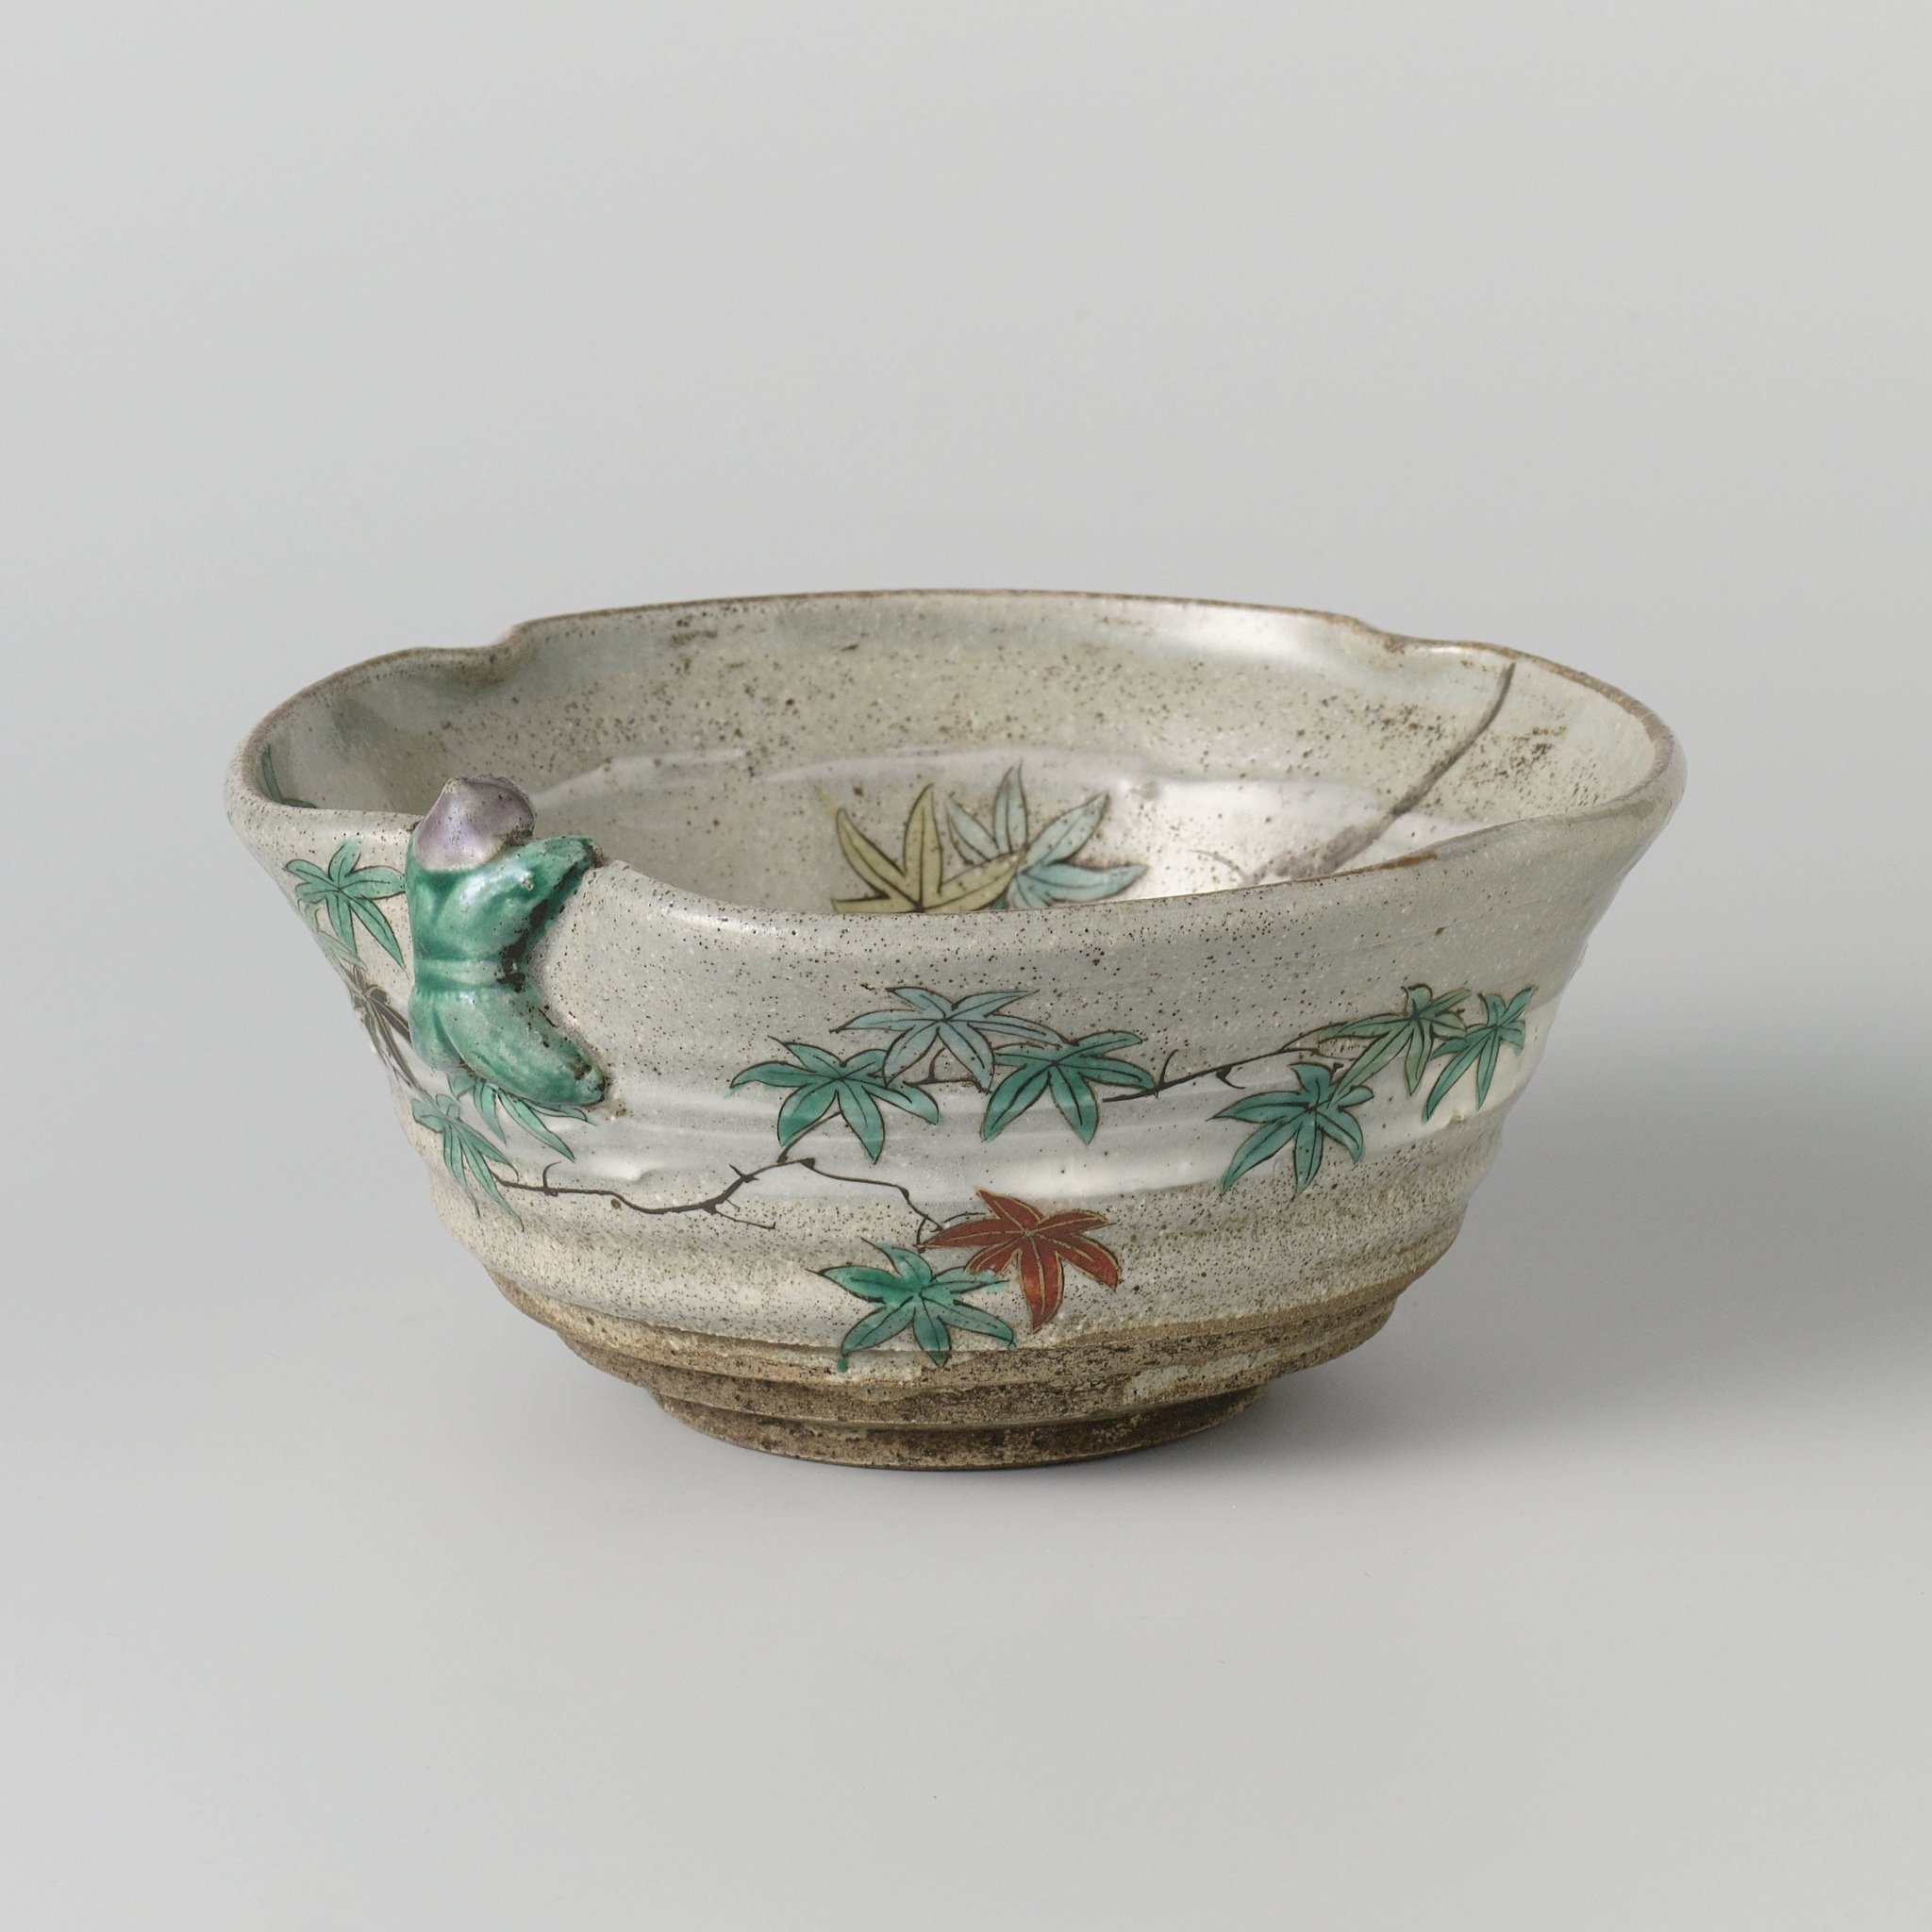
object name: bowl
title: Bowl with birds, branches and a moulded figure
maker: Anonymous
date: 1800-1899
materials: glaze, gold, paint, porcelain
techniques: firing, forming, turning, vitrification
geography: kutani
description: Kom van steengoed, gedeeltelijk bedekt met een grijs glazuur en beschilderd op het glazuur in rood, groen, geel, zwart en goud. Op de buitenwand een tak met bladeren (ahorn) en op de rand een klein gemodelleerd figuurtje van een Chinees. De binnenwand en bodem met twee vogels op een ahorntak. Kutani[?].